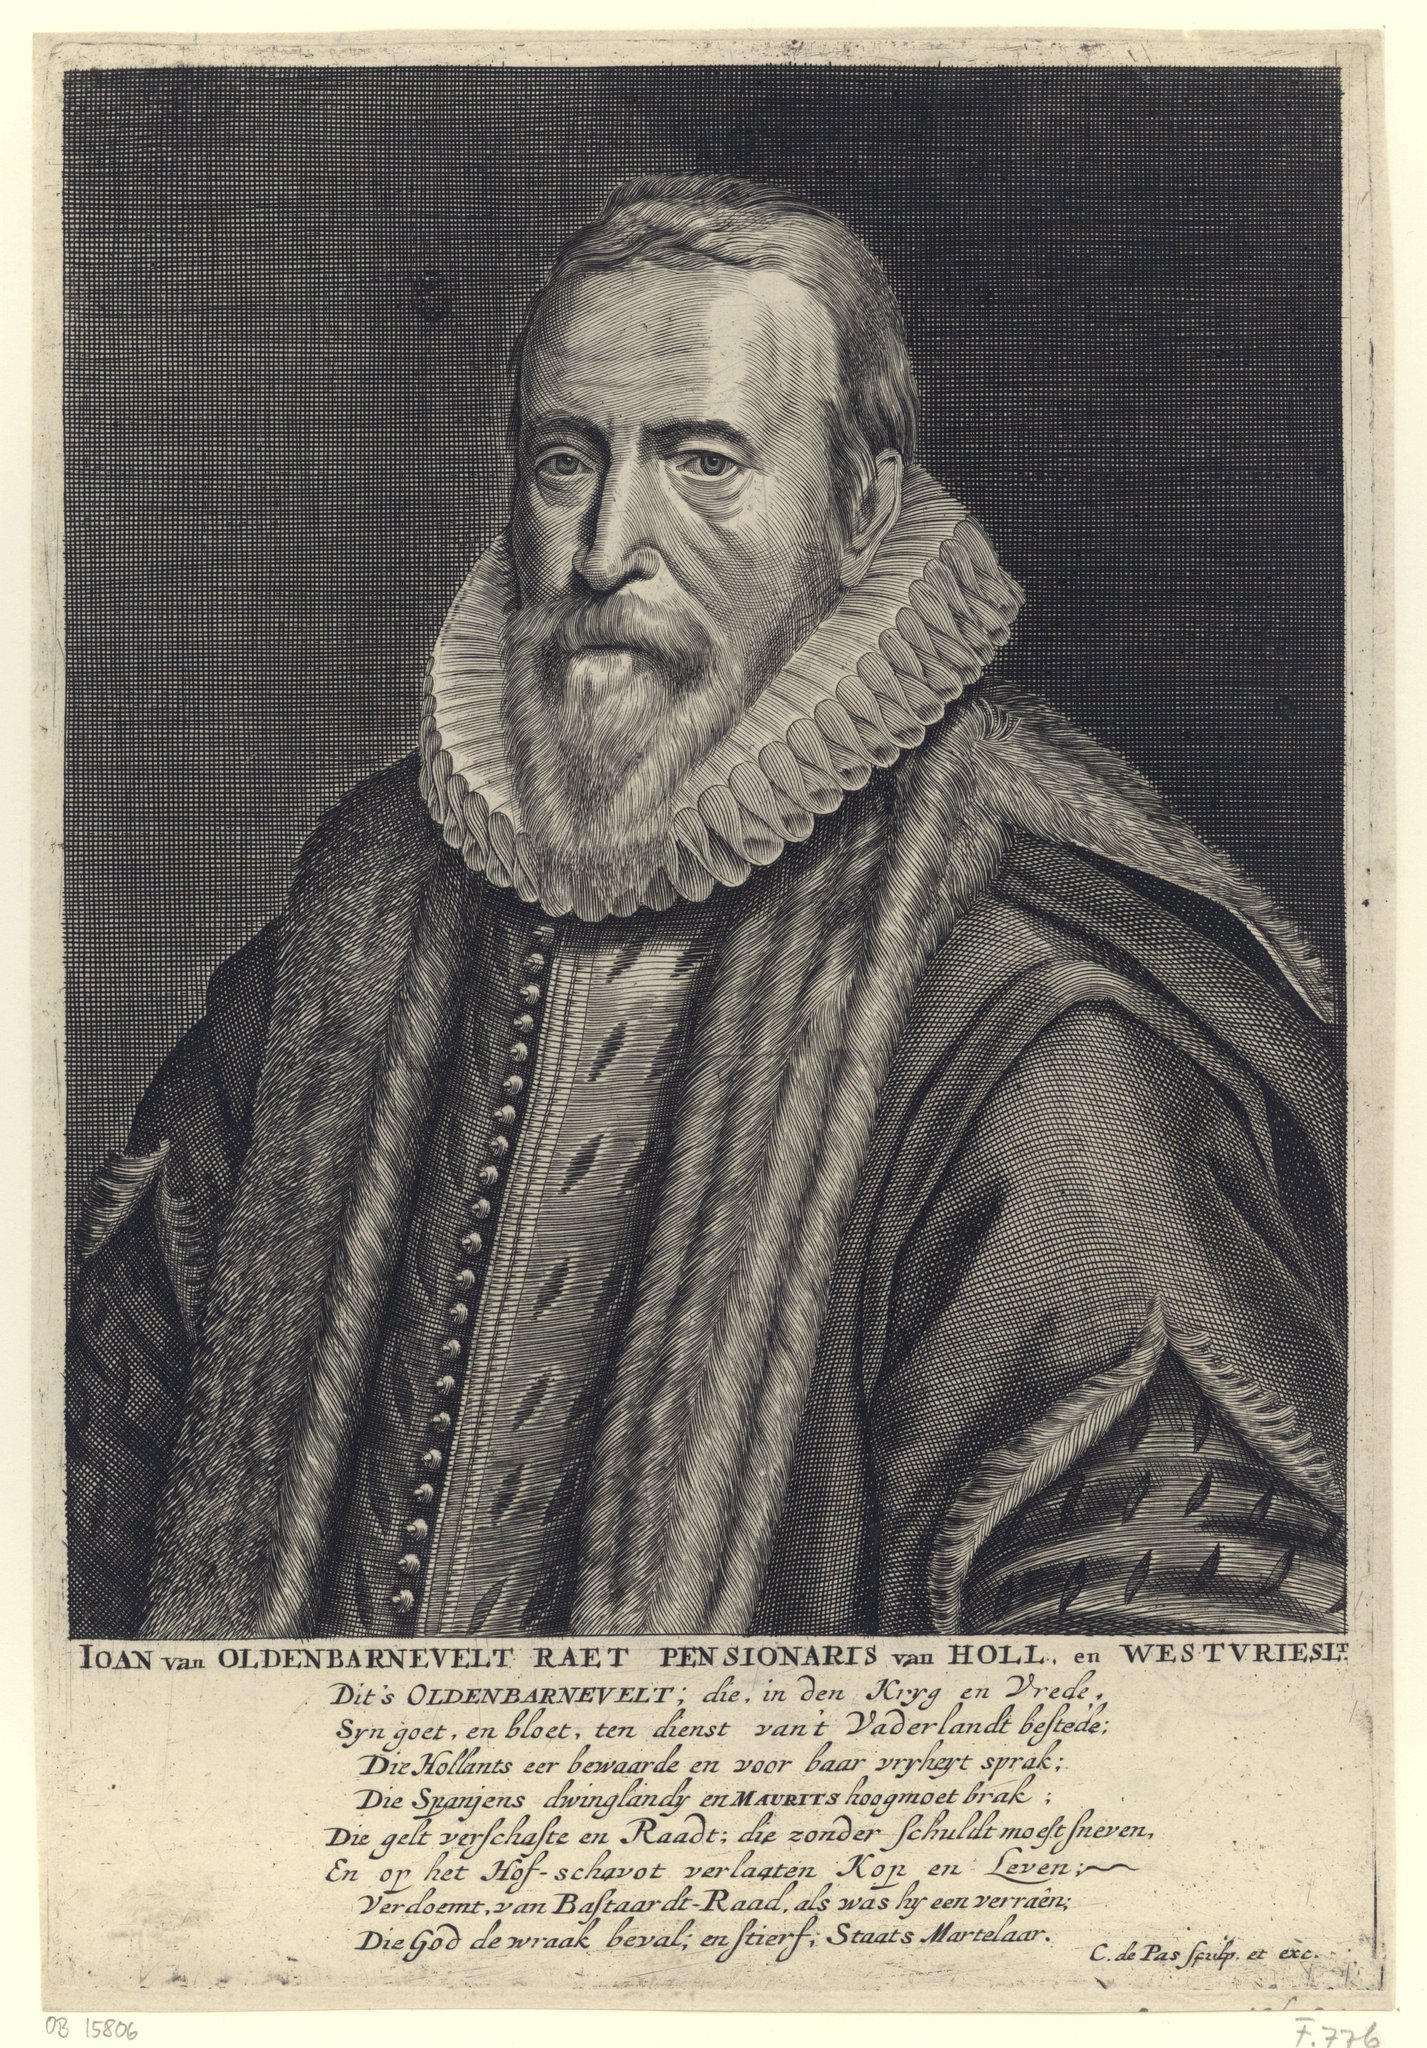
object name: print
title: Portret van Johan van Oldenbarnevelt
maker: crispijn van de passe (ii)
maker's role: draughtsman, print maker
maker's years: 1594-1670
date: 1619-1650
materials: paper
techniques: engraving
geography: amsterdam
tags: the hague, johan van oldenbarnevelt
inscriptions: collector's mark: Lugt 240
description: Portret van Johan van Oldenbarnevelt. Onder het portret een Hollands vers van acht regels waarin Van Oldenbarnevelt als martelaar en slachtoffer van Maurits' hoogmoed wordt geëerd. Het is onduidelijk of het portret is gegraveerd en uitgegeven door Crispijn de Passe de Oude of de Jonge. De toeschrijving in Hollstein aan de zoon wordt hier aangehouden. Wellicht gaat het portret terug op het schilderij van Michiel van Miereveld